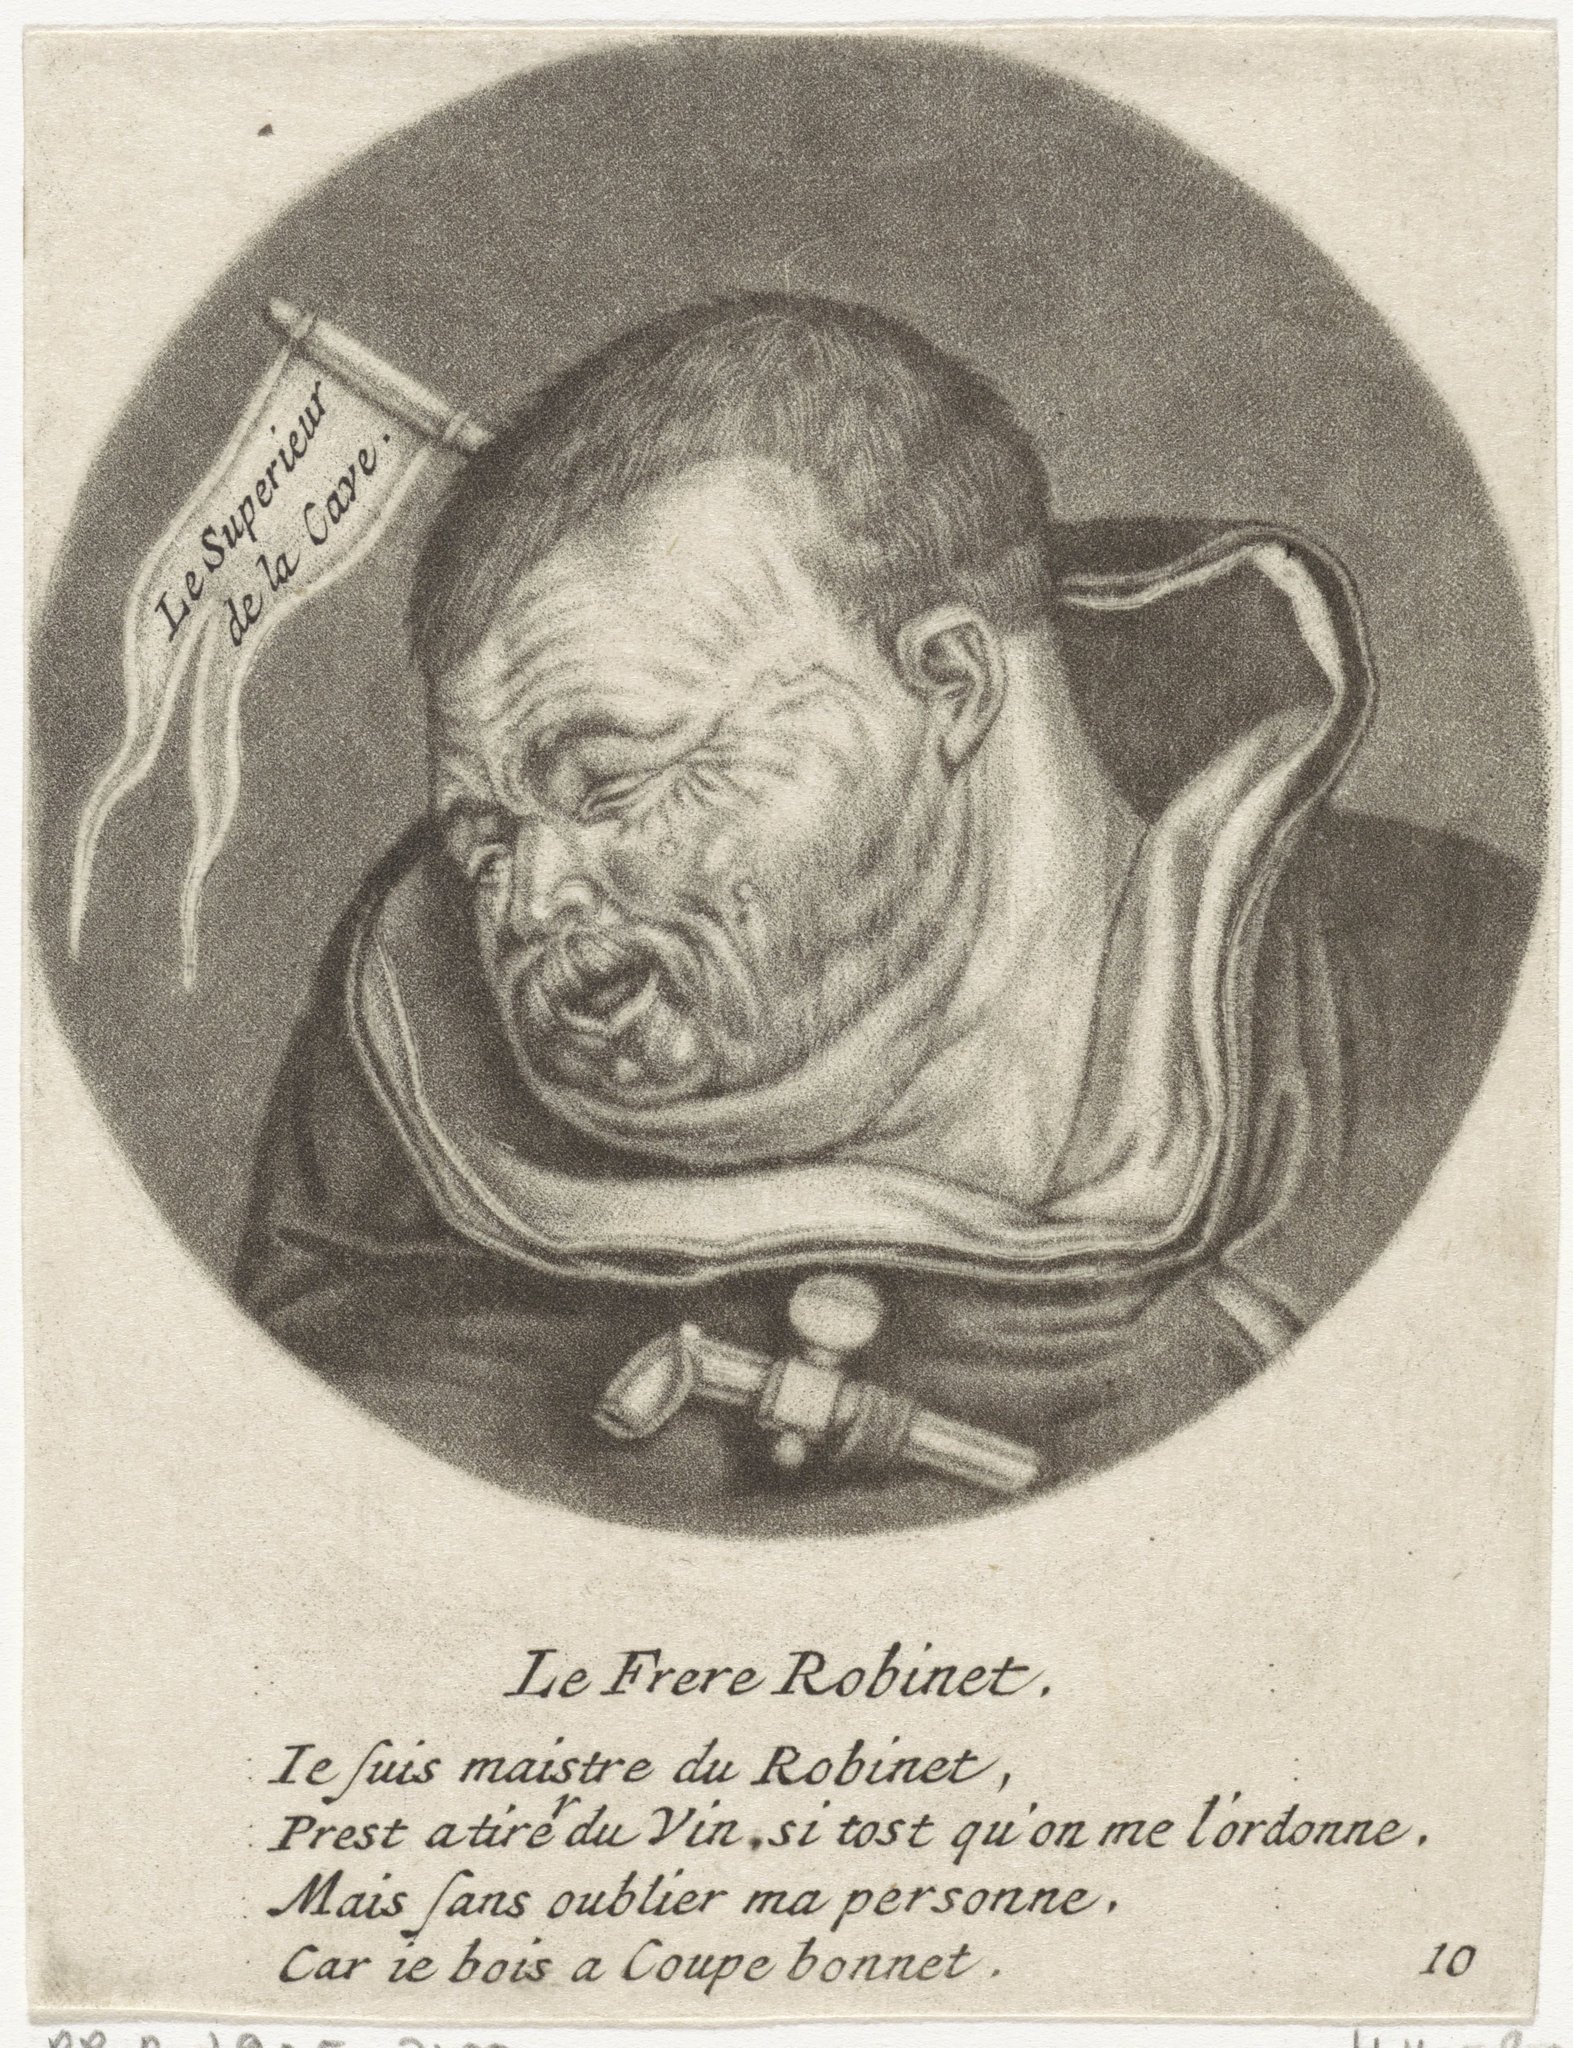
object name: print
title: Monnik met een pijp en een vlag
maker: jacob gole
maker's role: print maker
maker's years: 1660-1724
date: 1670-1724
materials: paper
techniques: engraving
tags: pipe ~ tobacco, monk(s), friar(s), political caricatures and satires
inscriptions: collector's mark: Lugt 2228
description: Monnik met in zijn kap een vlag waarop de tekst "Le Superieur de la Cave". Op zijn borst een pijp. De prent maakt deel uit van een serie met karikaturen van de Franse geestelijkheid onder Lodewijk XIV.